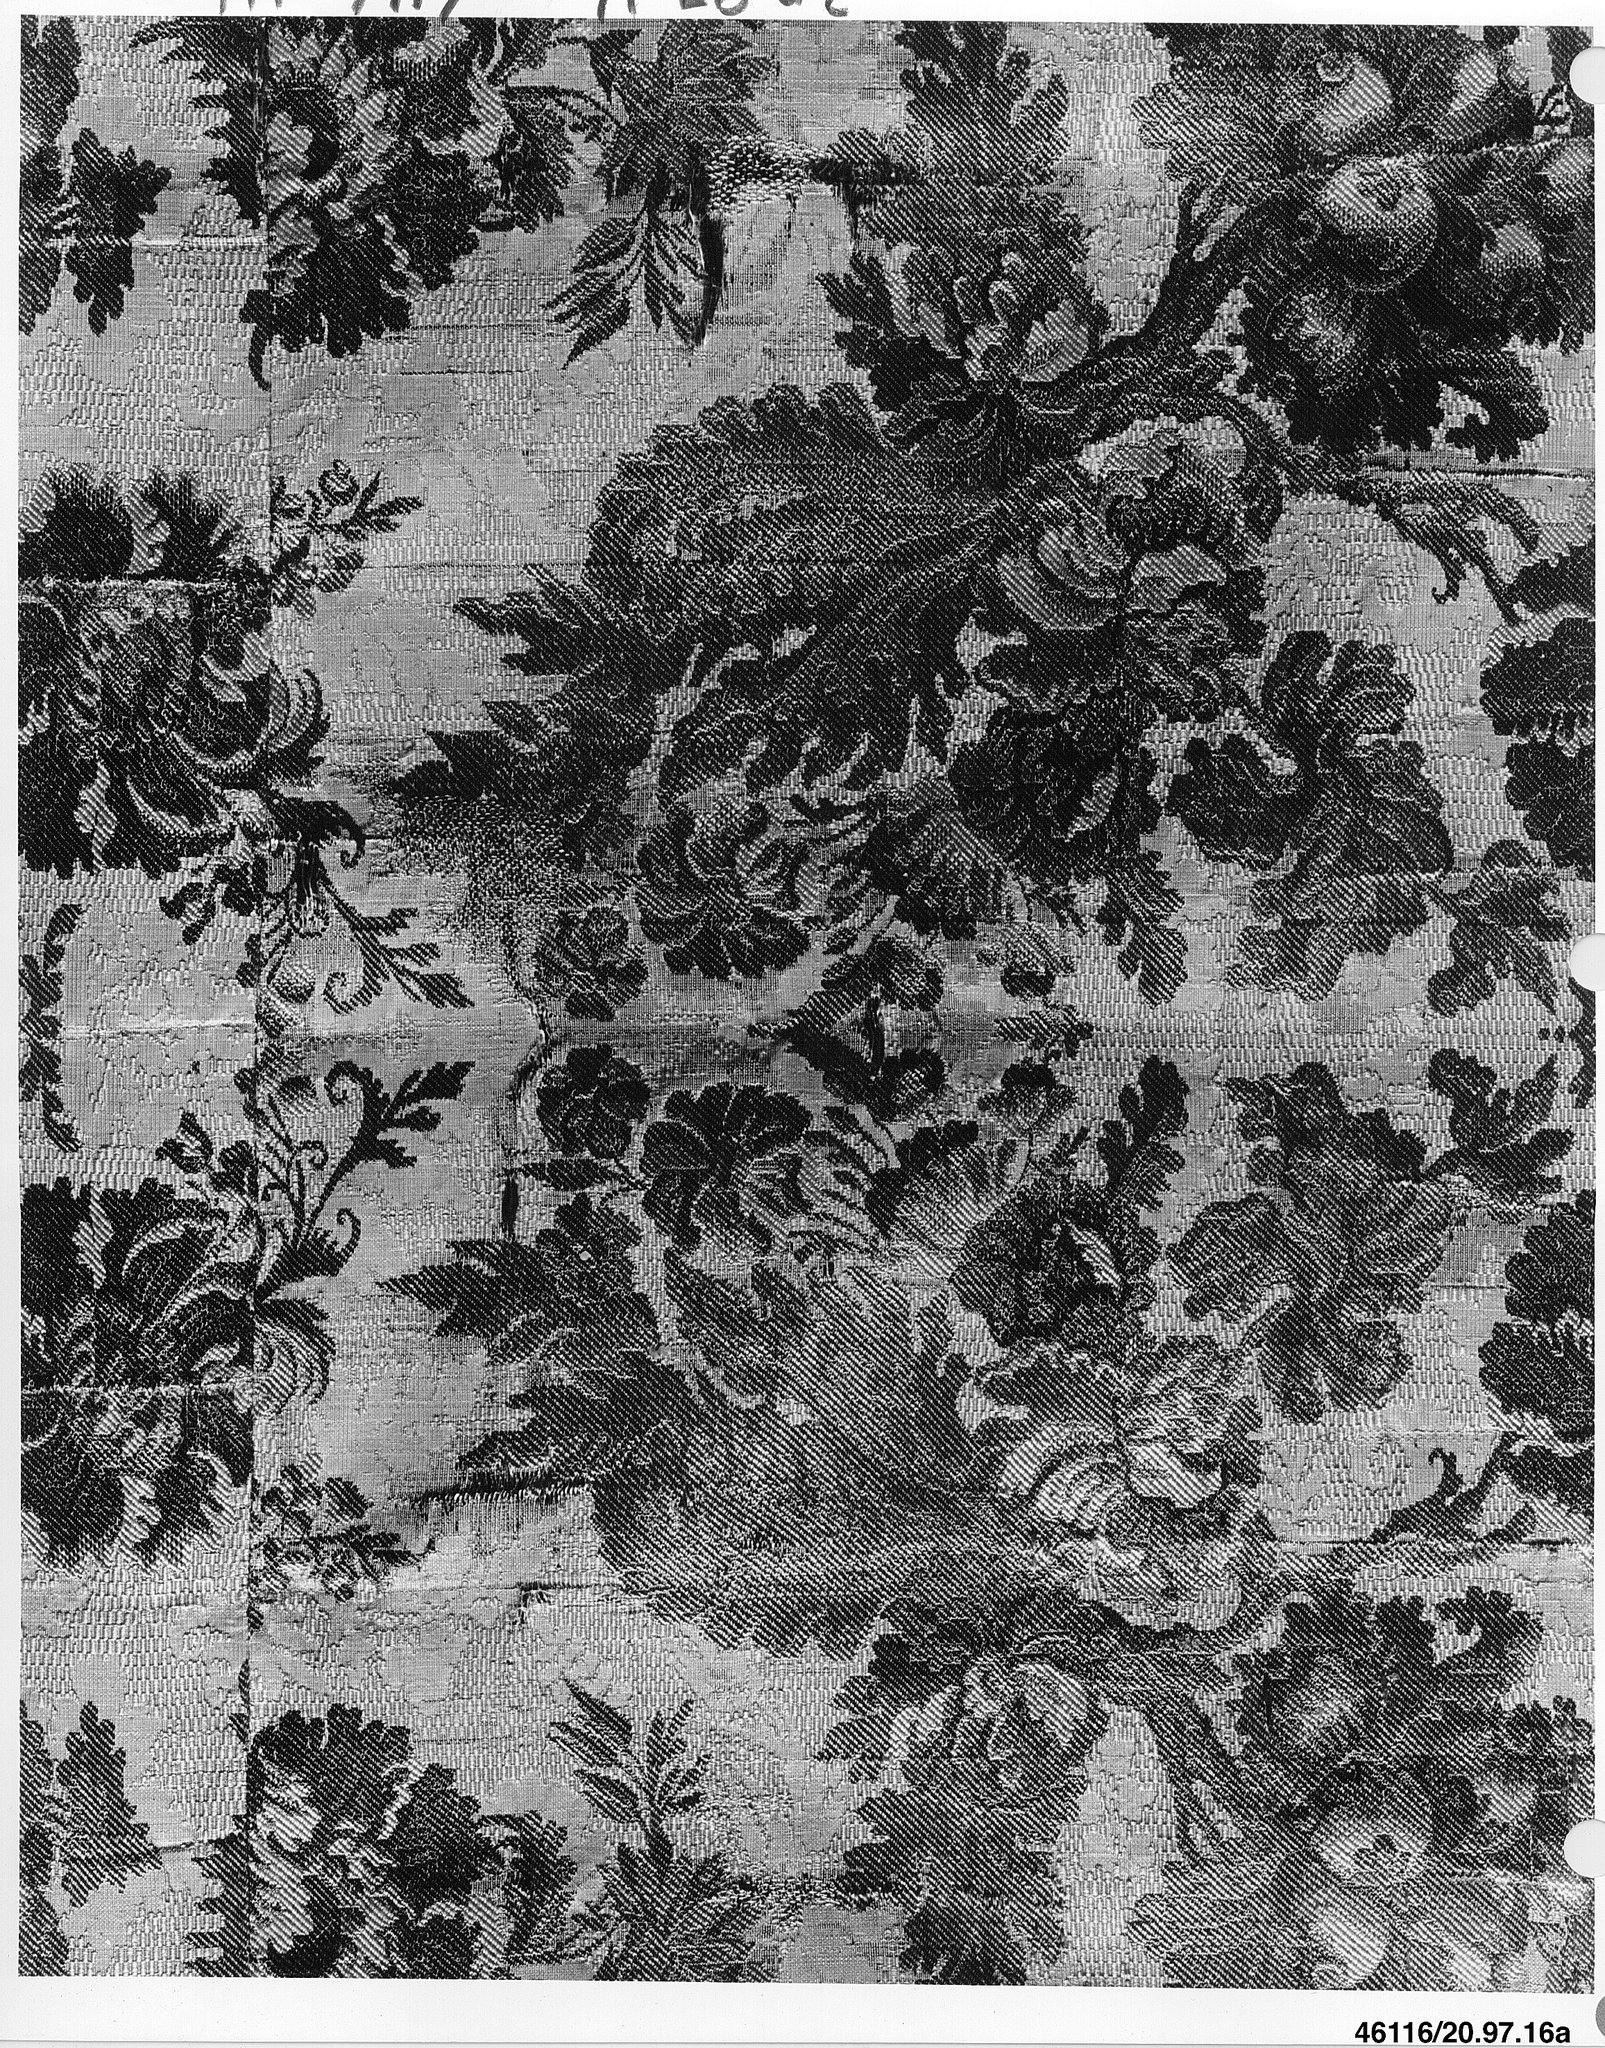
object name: piece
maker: jean revel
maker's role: designer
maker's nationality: french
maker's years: 1684-1751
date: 1735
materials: silk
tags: flowers,leaves